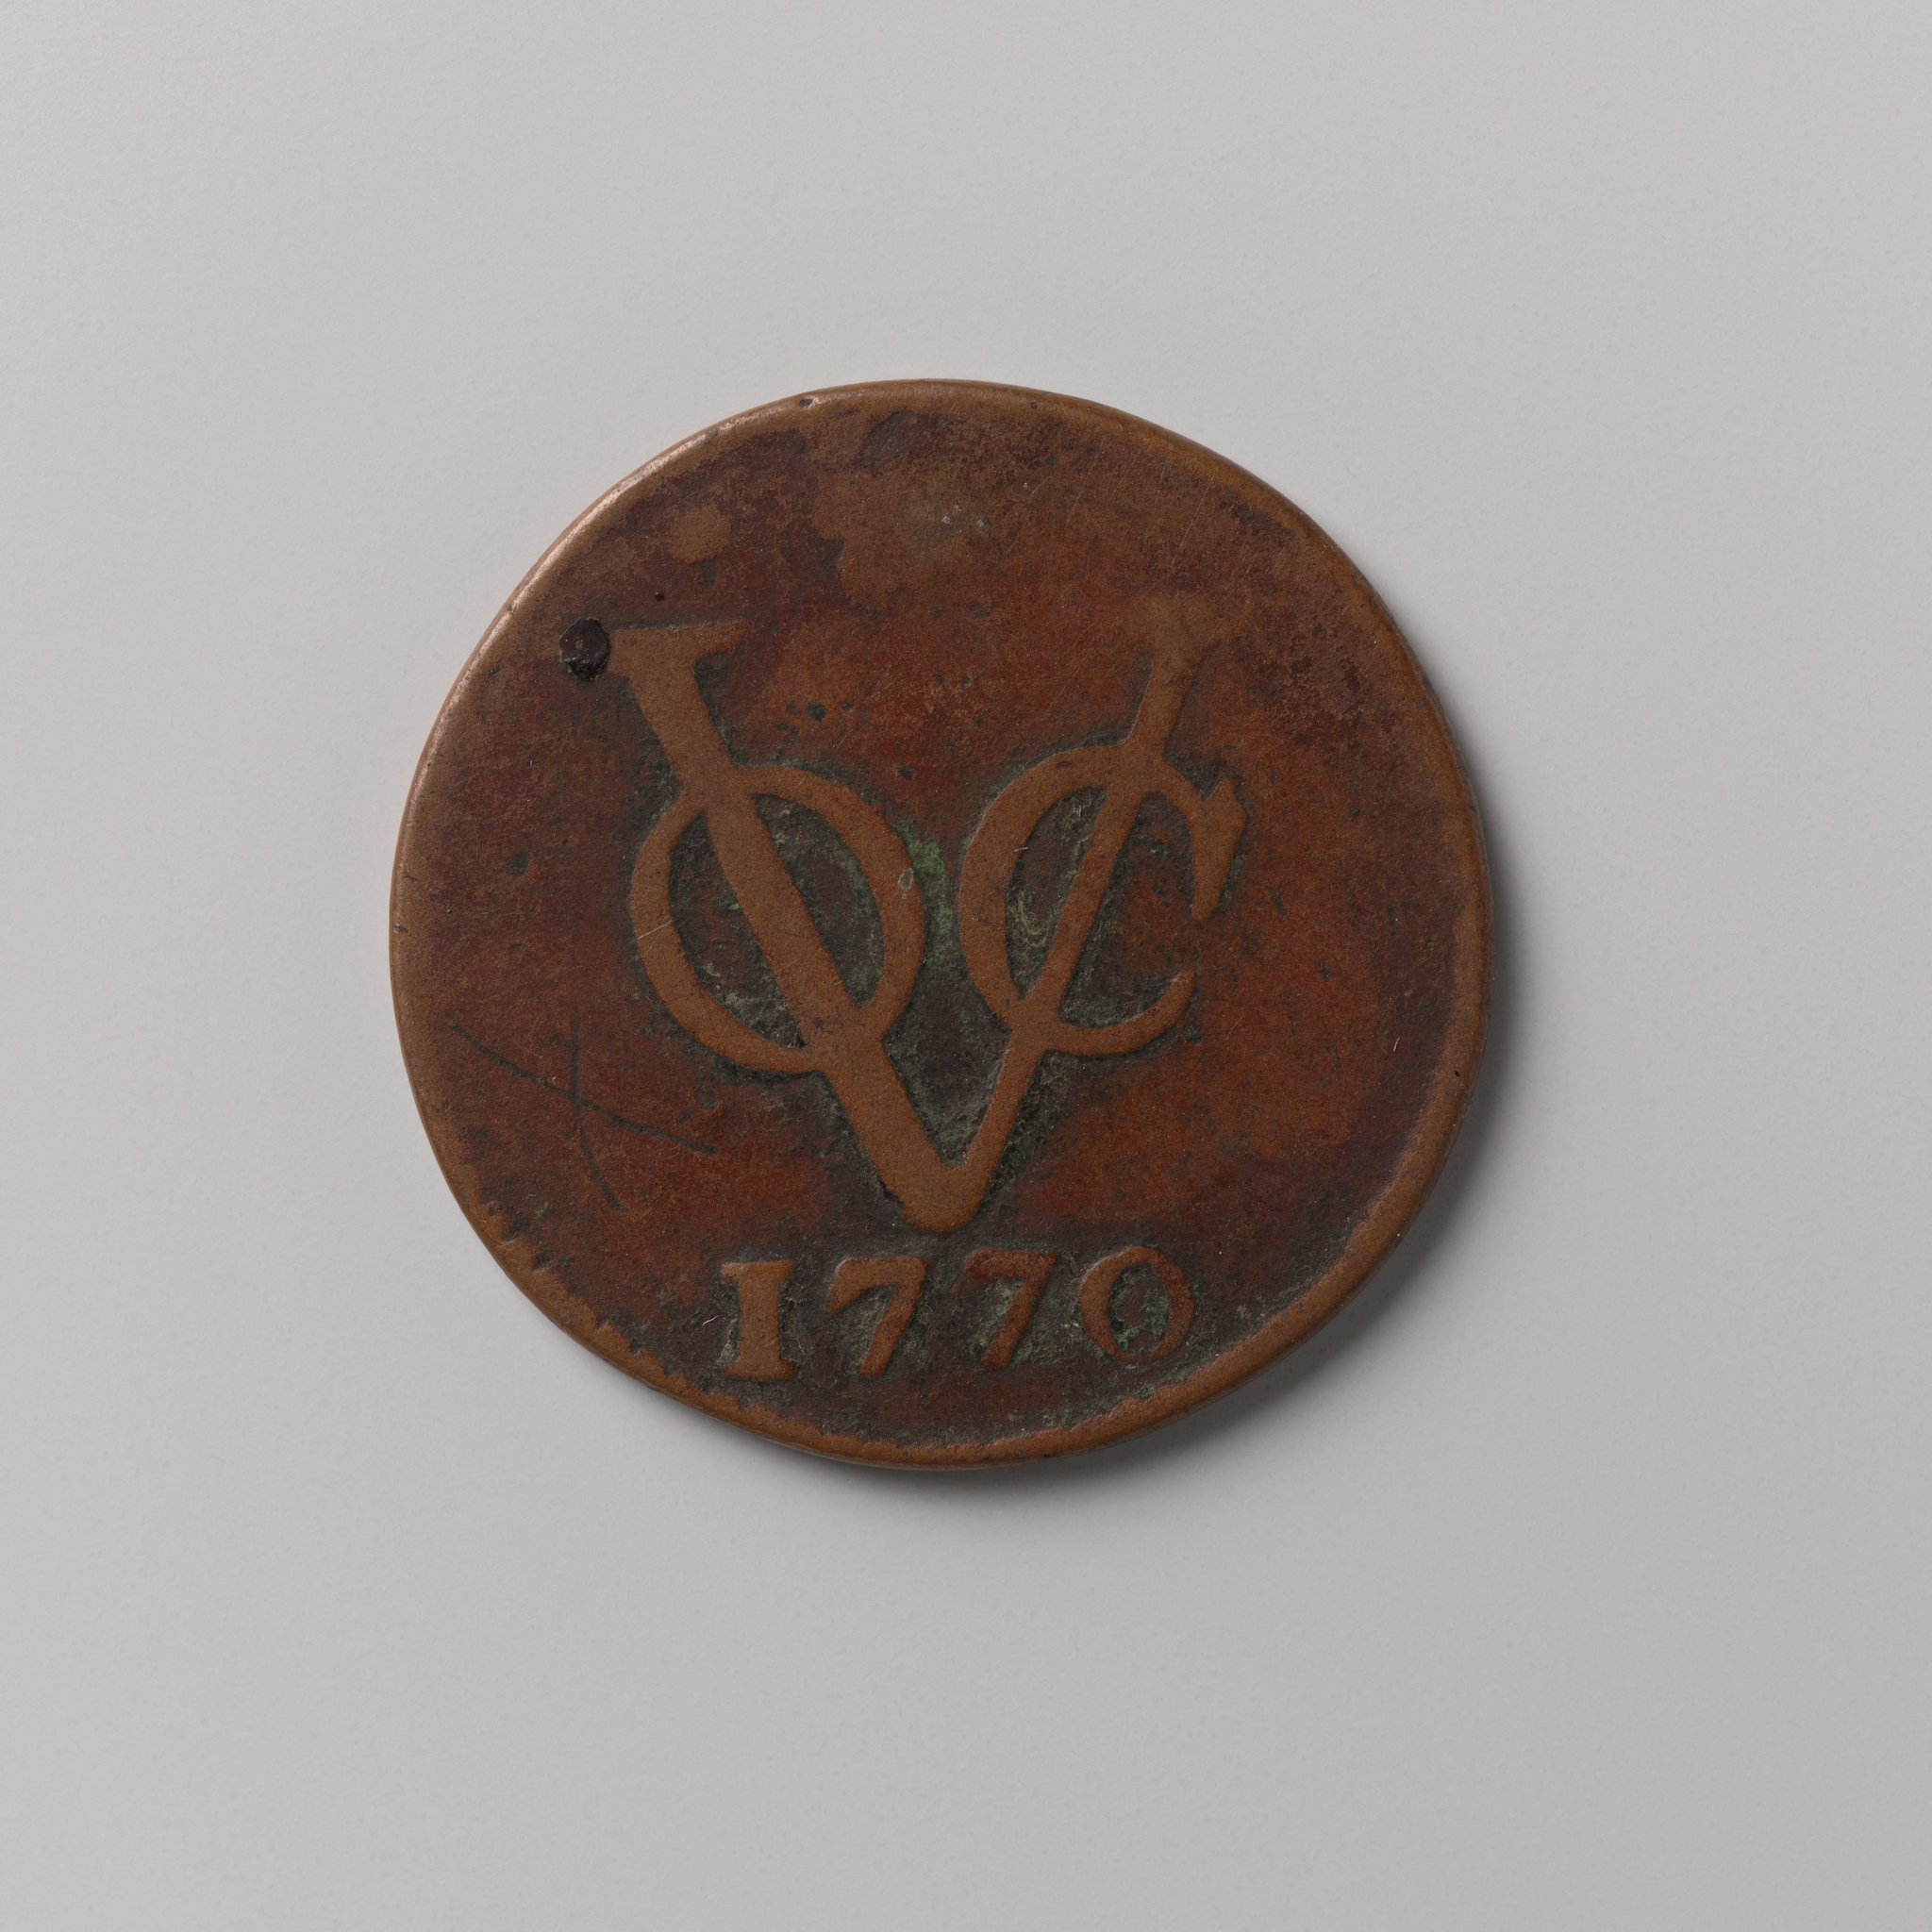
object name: coin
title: Duit van de VOC uit Holland, 1770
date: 1770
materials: copper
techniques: striking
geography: dordrecht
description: Koperen munt. Voorzijde: gekroond wapenschild van Holland. Keerzijde: monogram van de VOC, waarboven muntteken en waaronder jaartal. Gladde rand.